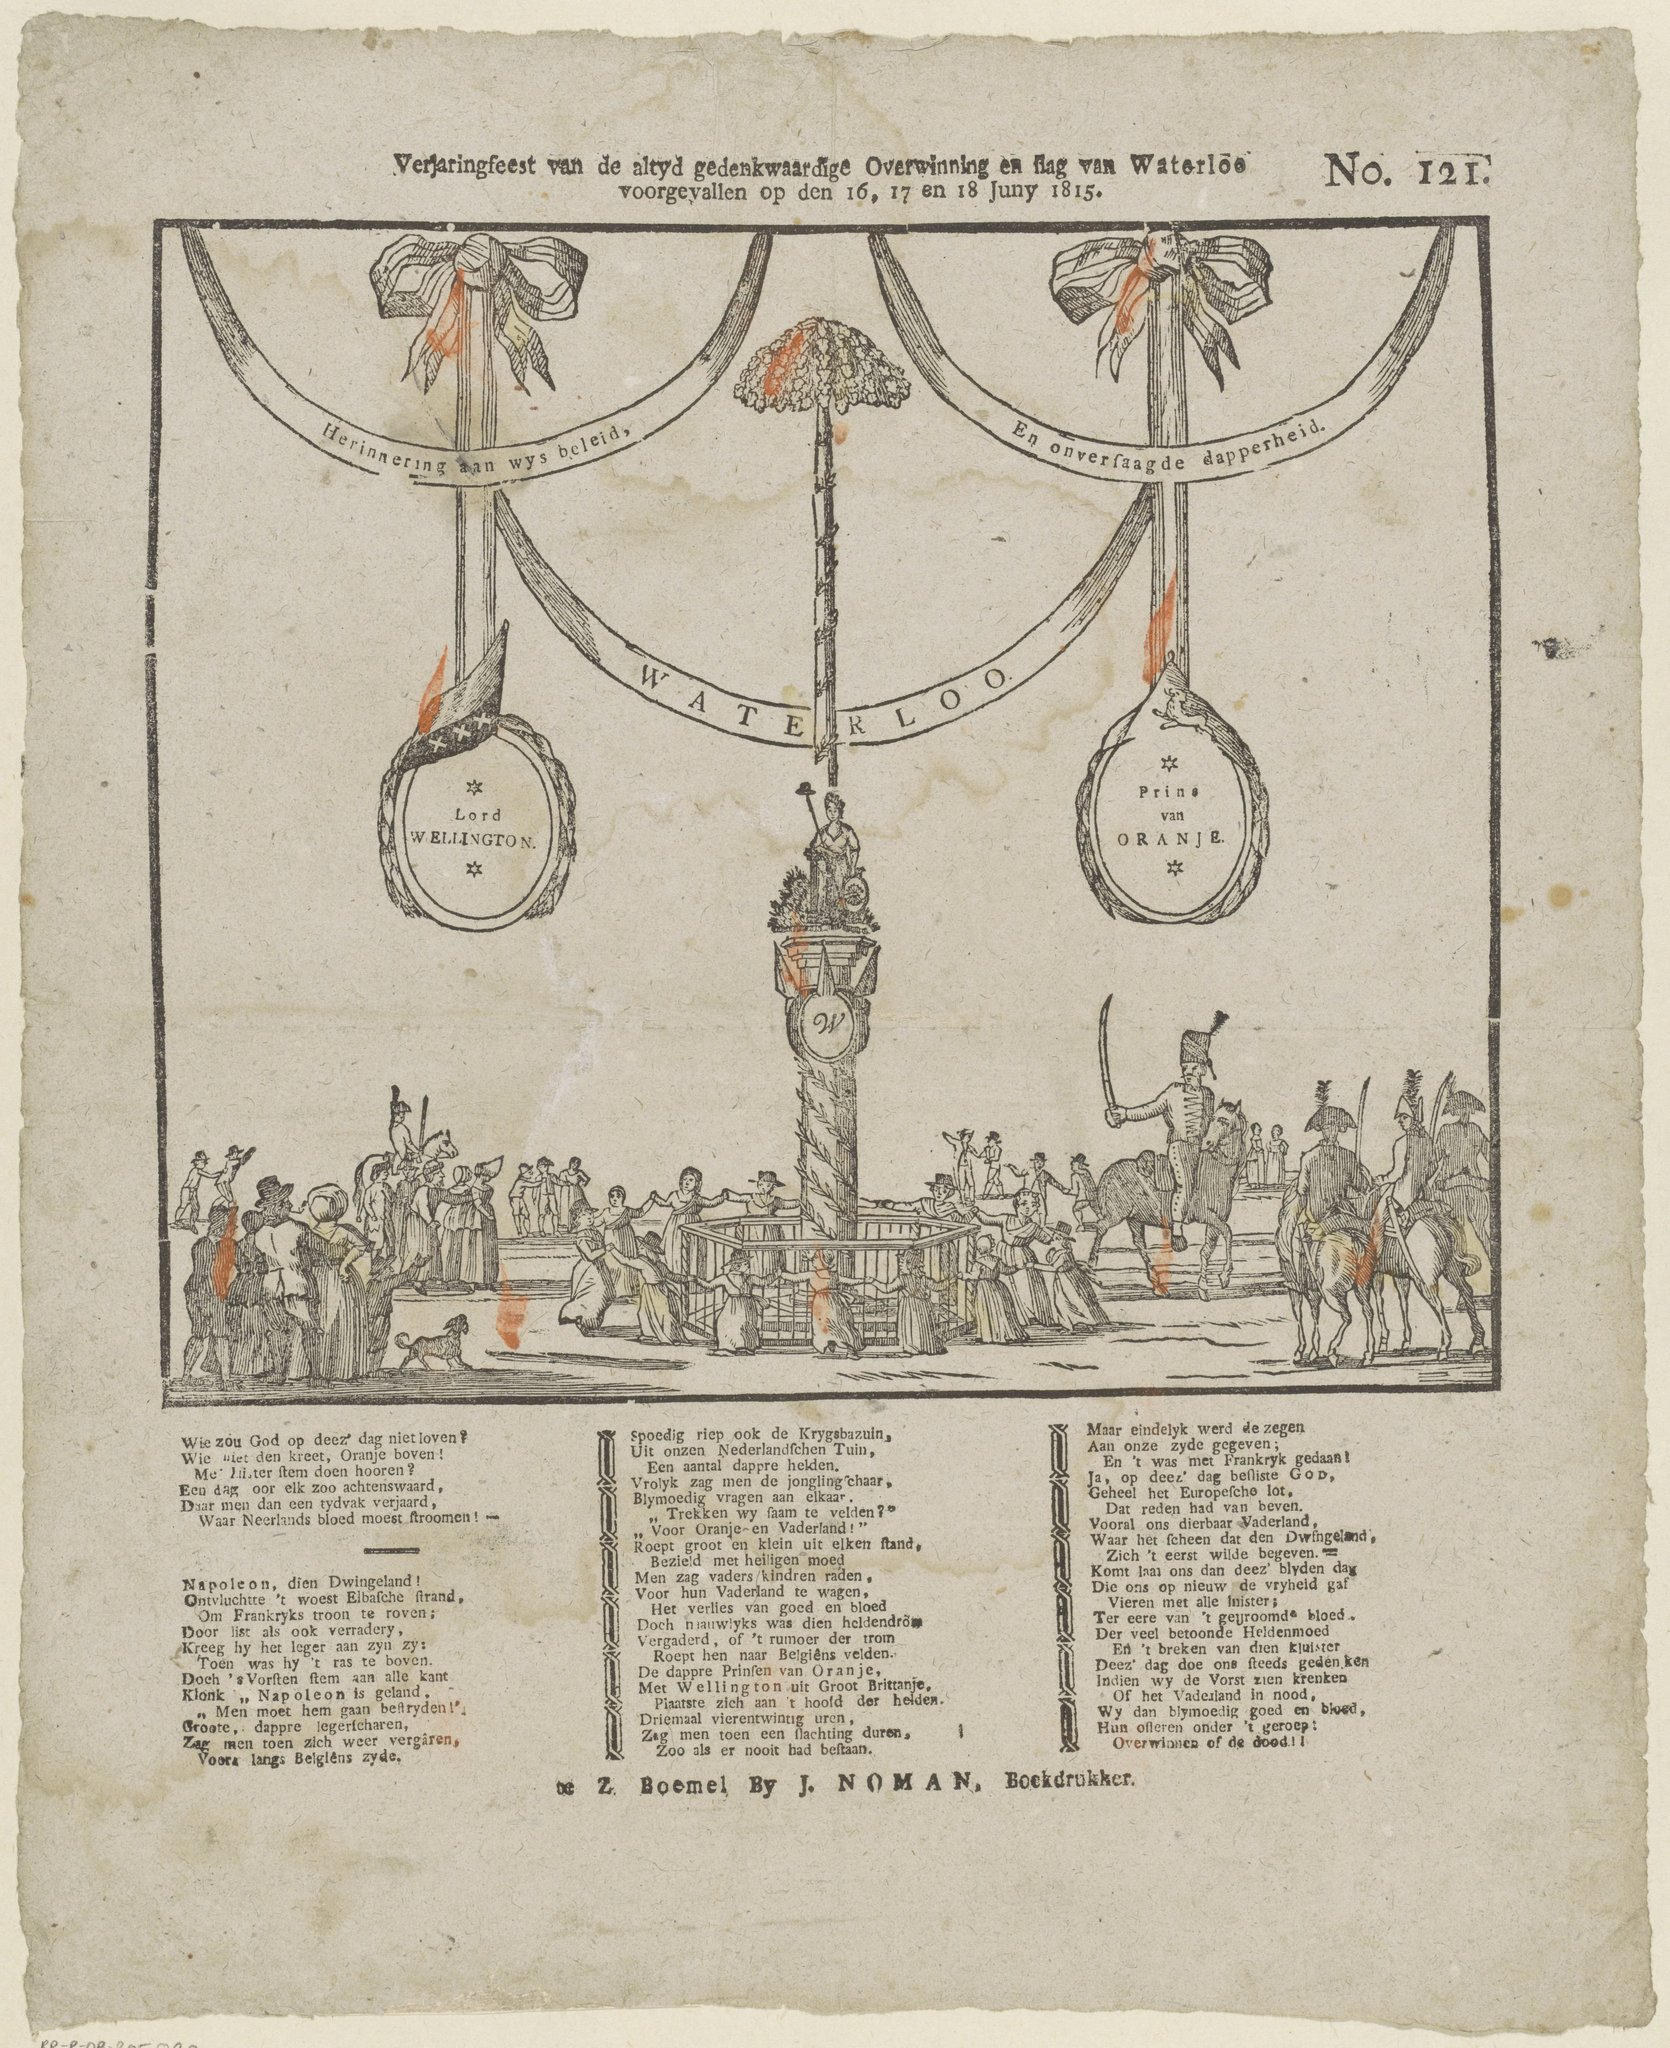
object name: popular print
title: Verjaringfeest van de altyd gedenkwaardige overwinning en slag van Waterloo / voorgevallen op den 16, 17 en 18 juny 1815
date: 1806-1830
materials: paper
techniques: colour, letterpress printing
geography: netherlands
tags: berlin, william i of the netherlands, arthur wellesley of wellington, napoleon i (emperor of the french), reunion, memorial gathering (~ veteran soldiers), group dancing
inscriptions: collector's mark: Lugt 2760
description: Blad met een grote voorstelling van een herdenkingsbijeenkomt om de Slag bij Waterloo te herdenken. In het midden danst een groep kinderen rond een zuil met een beeld erop. Daar omheen staat een groep mensen toe te kijken. Boven hangen banderollen en medaillons aan linten met teksten en namen erop. Onder de afbeelding een vers in drie kolommen. Genummerd rechtsboven: No. 121.